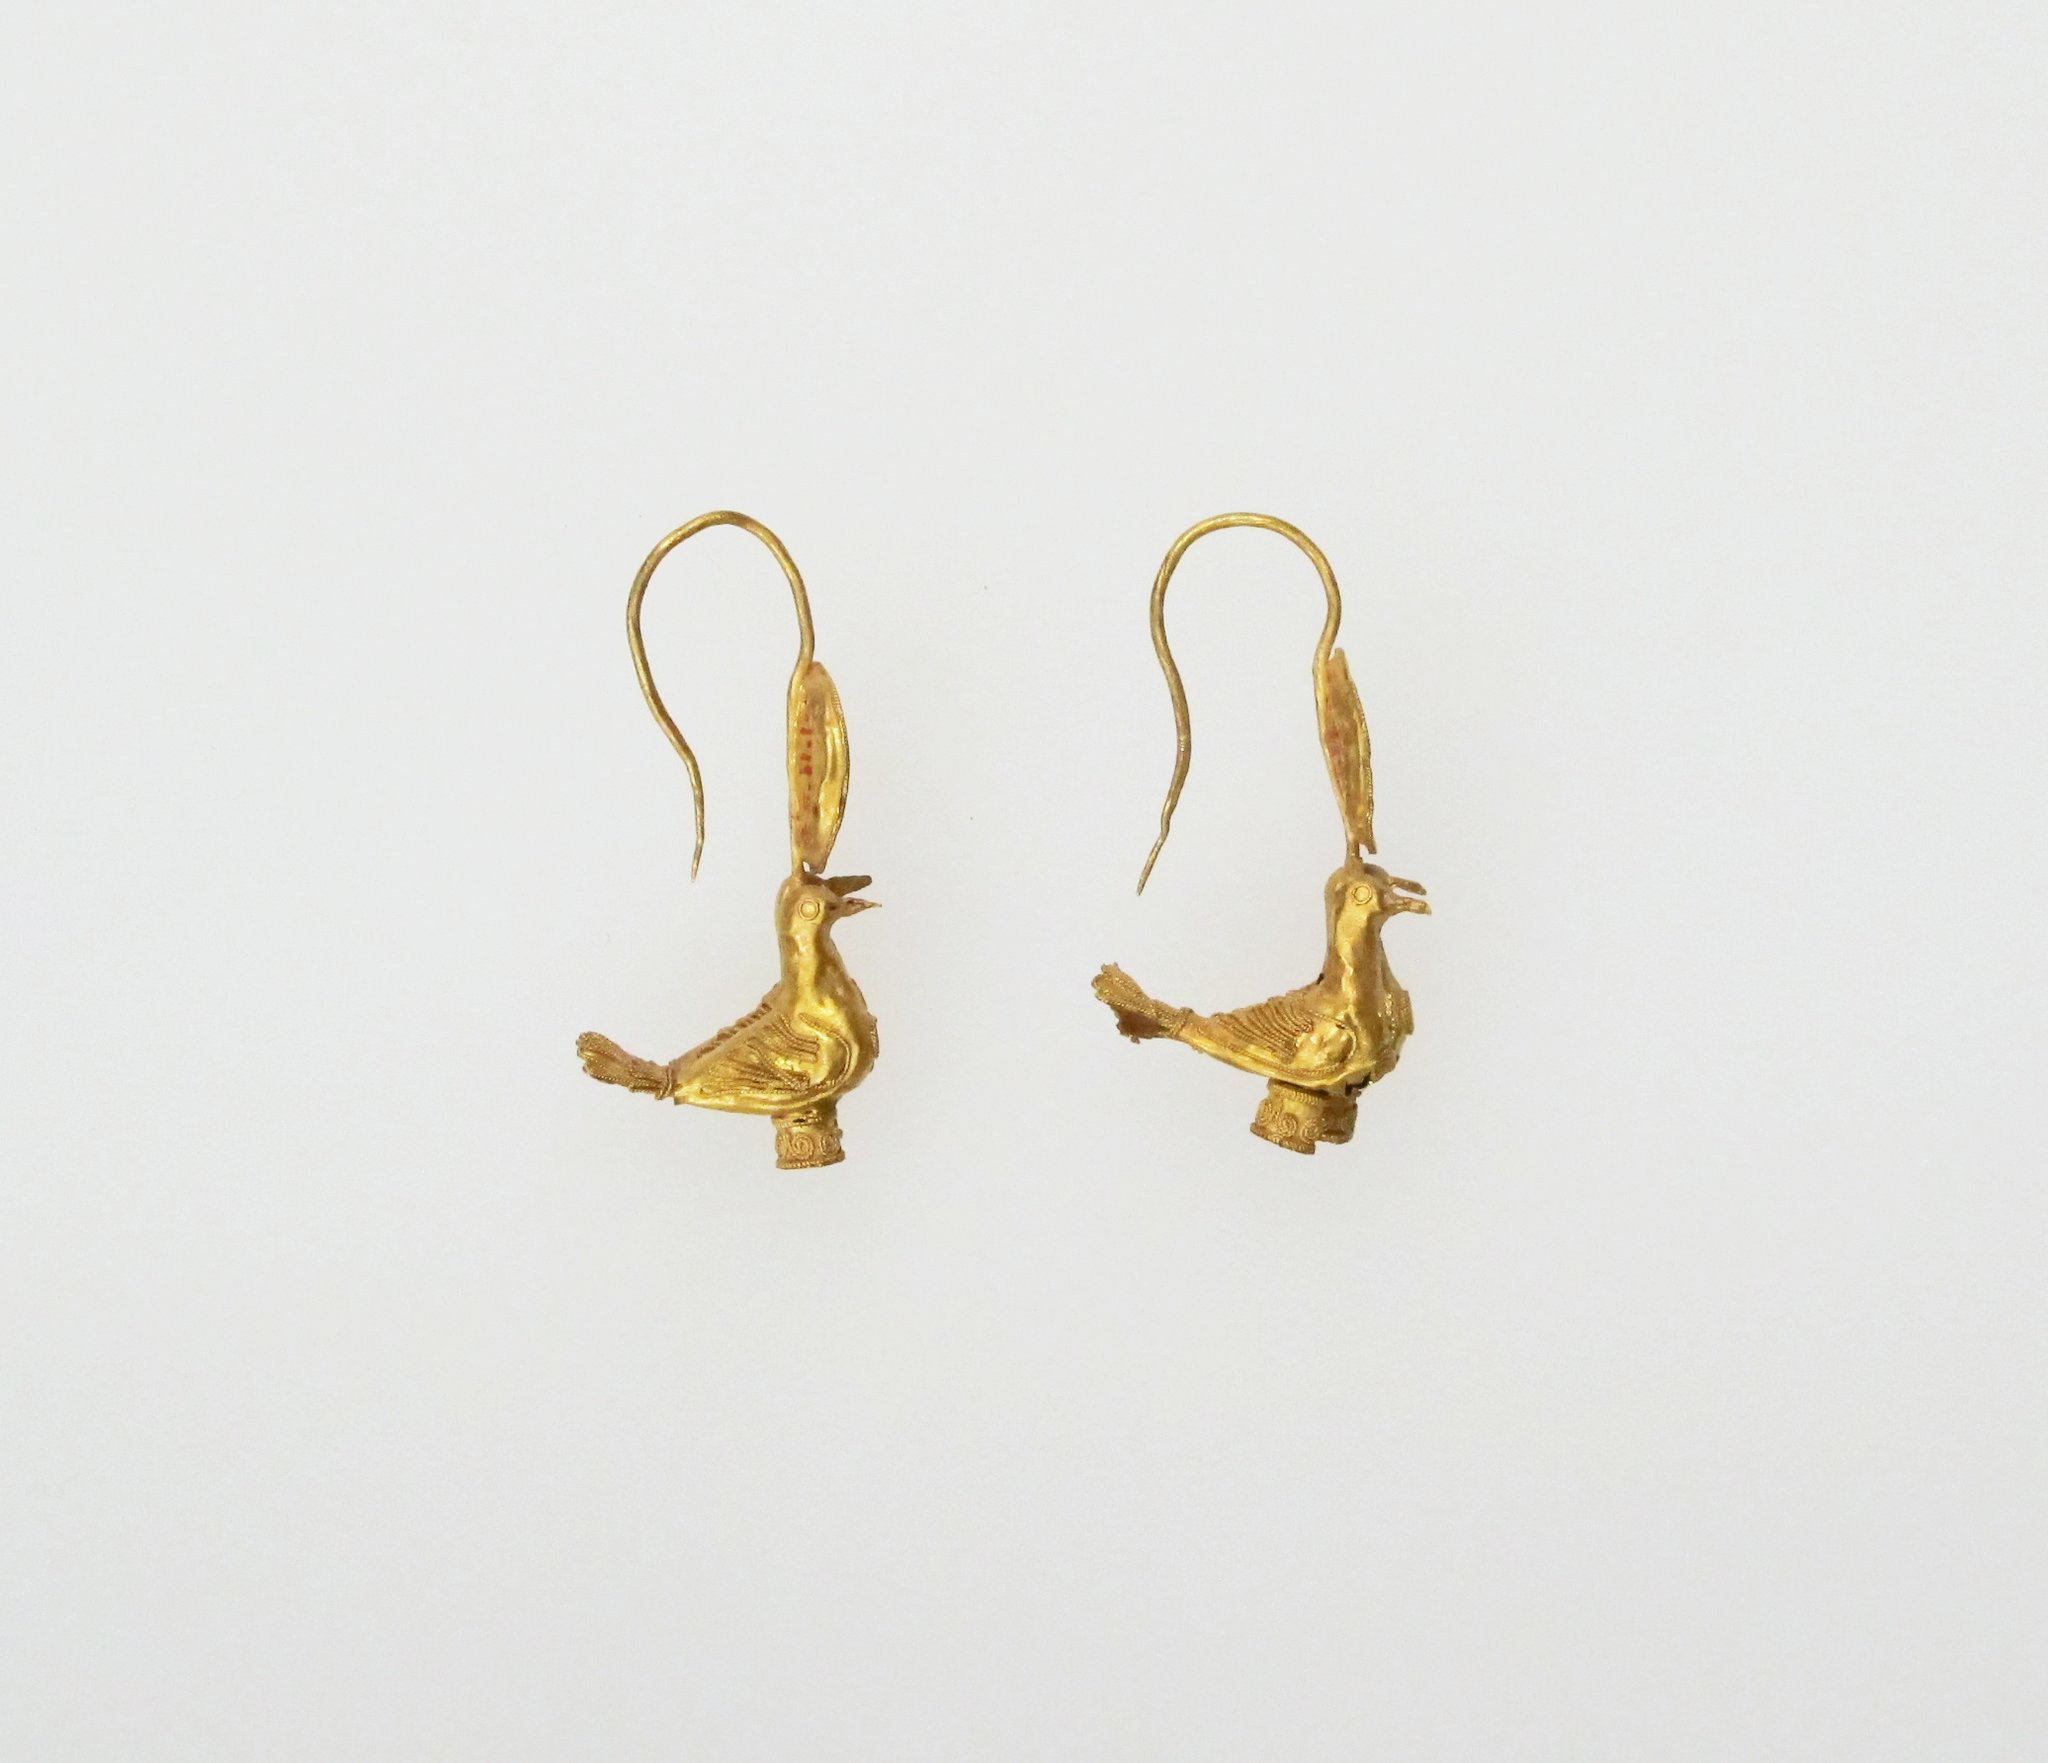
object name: earring with disc and pigeon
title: Earring with disc and pigeons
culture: greek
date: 400-301 BCE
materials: gold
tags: pigeons